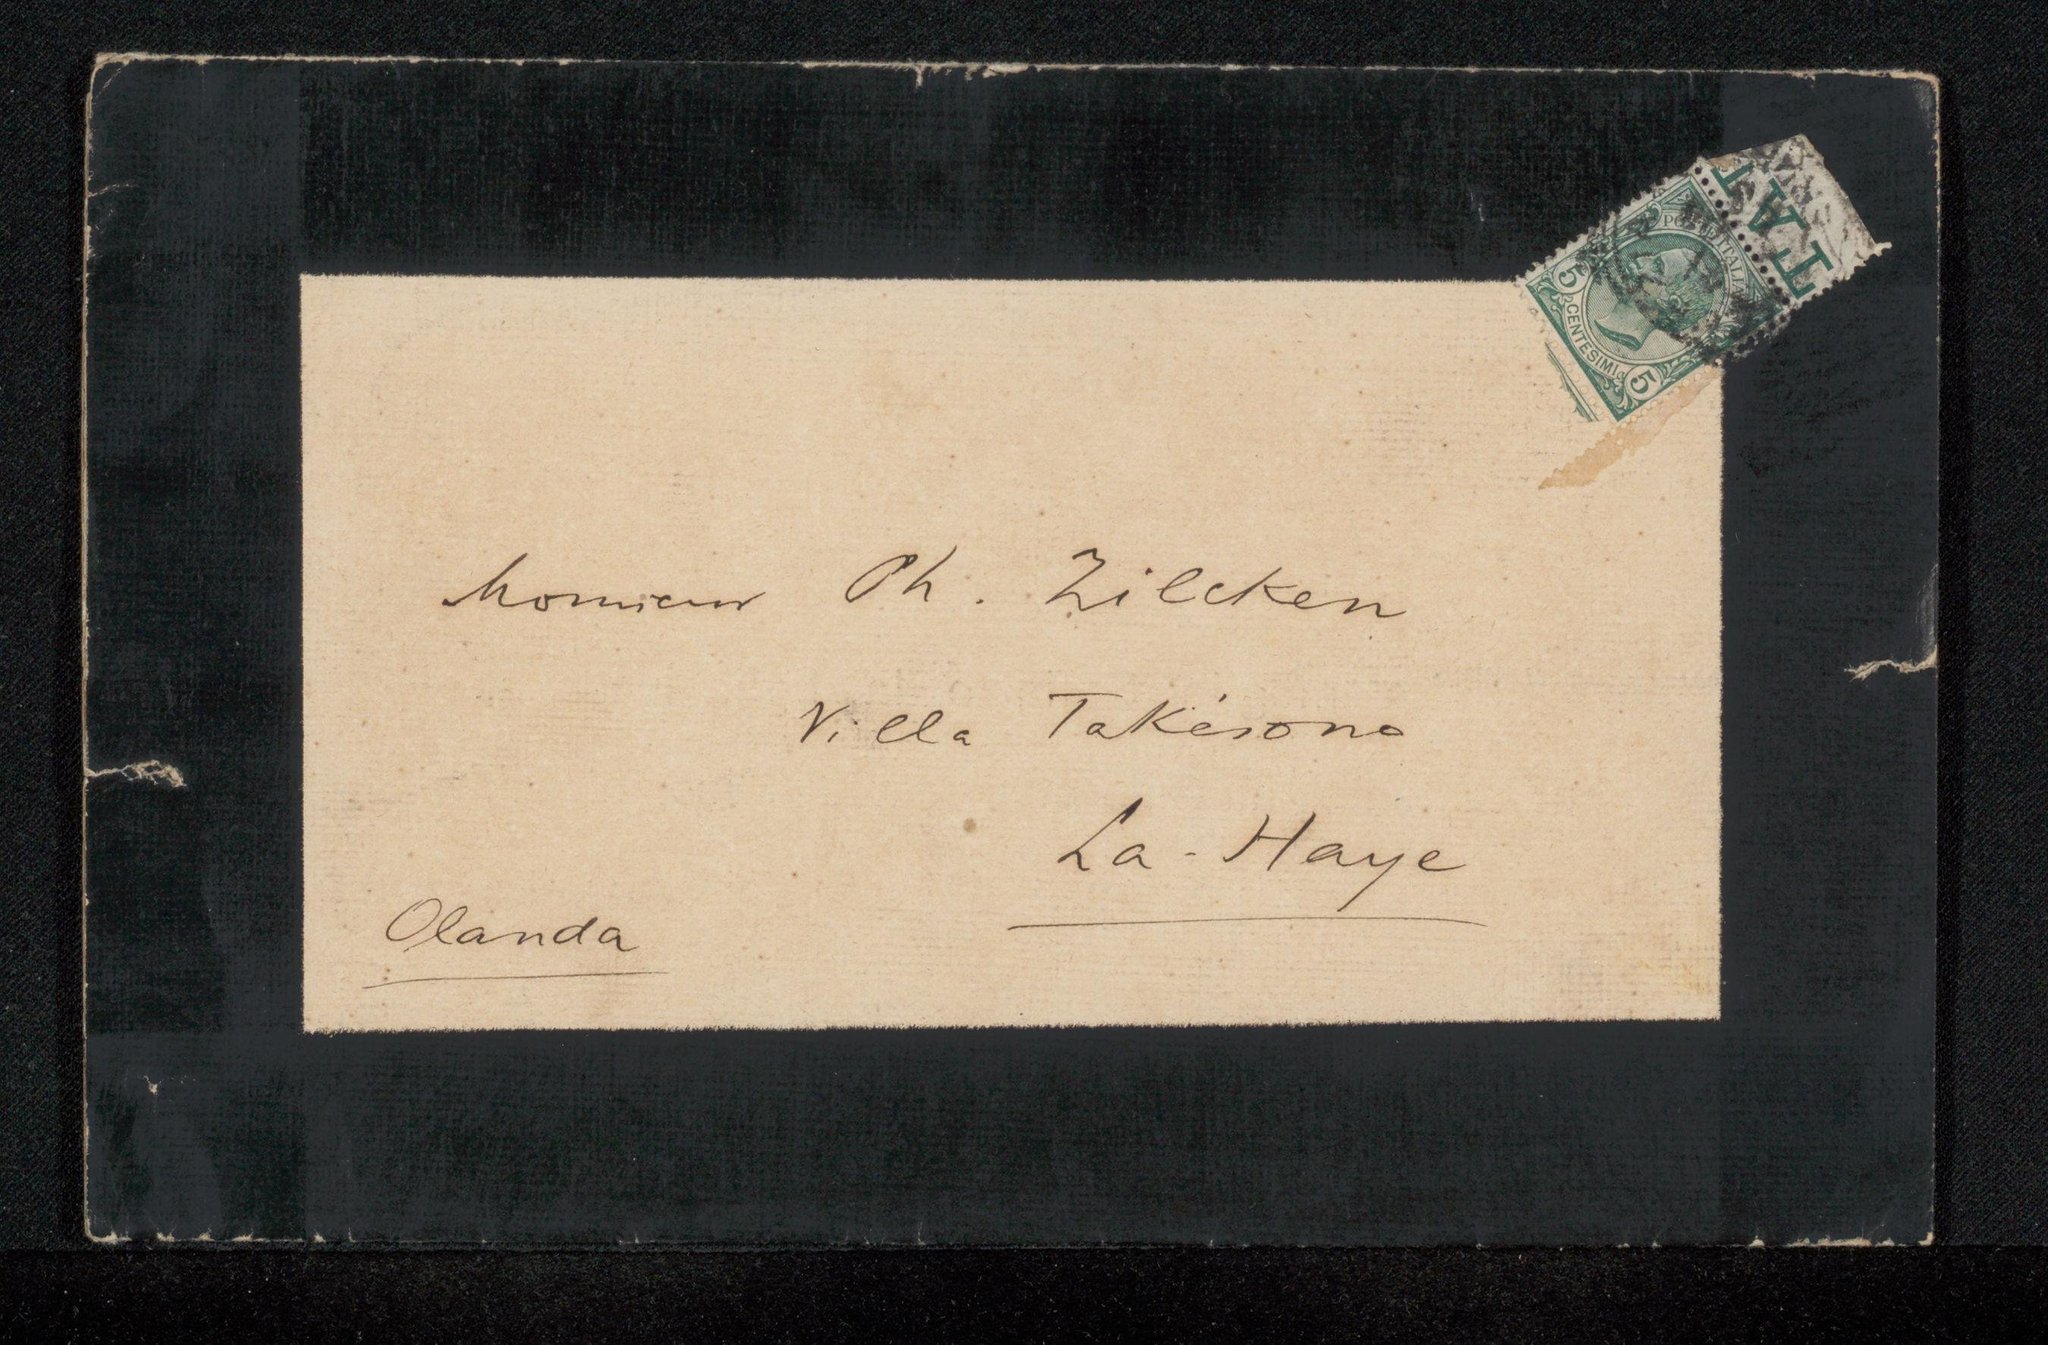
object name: overlijdensbericht, overlijdensadvertentie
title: Overlijdensbericht aan Philip Zilcken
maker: Anonymous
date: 1908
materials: ink, paper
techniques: pen, printing, writing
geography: venice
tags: venice, painter, martín rico ortega, the hague, draughtsman, philip zilcken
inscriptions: collector's mark: ‘RPK’